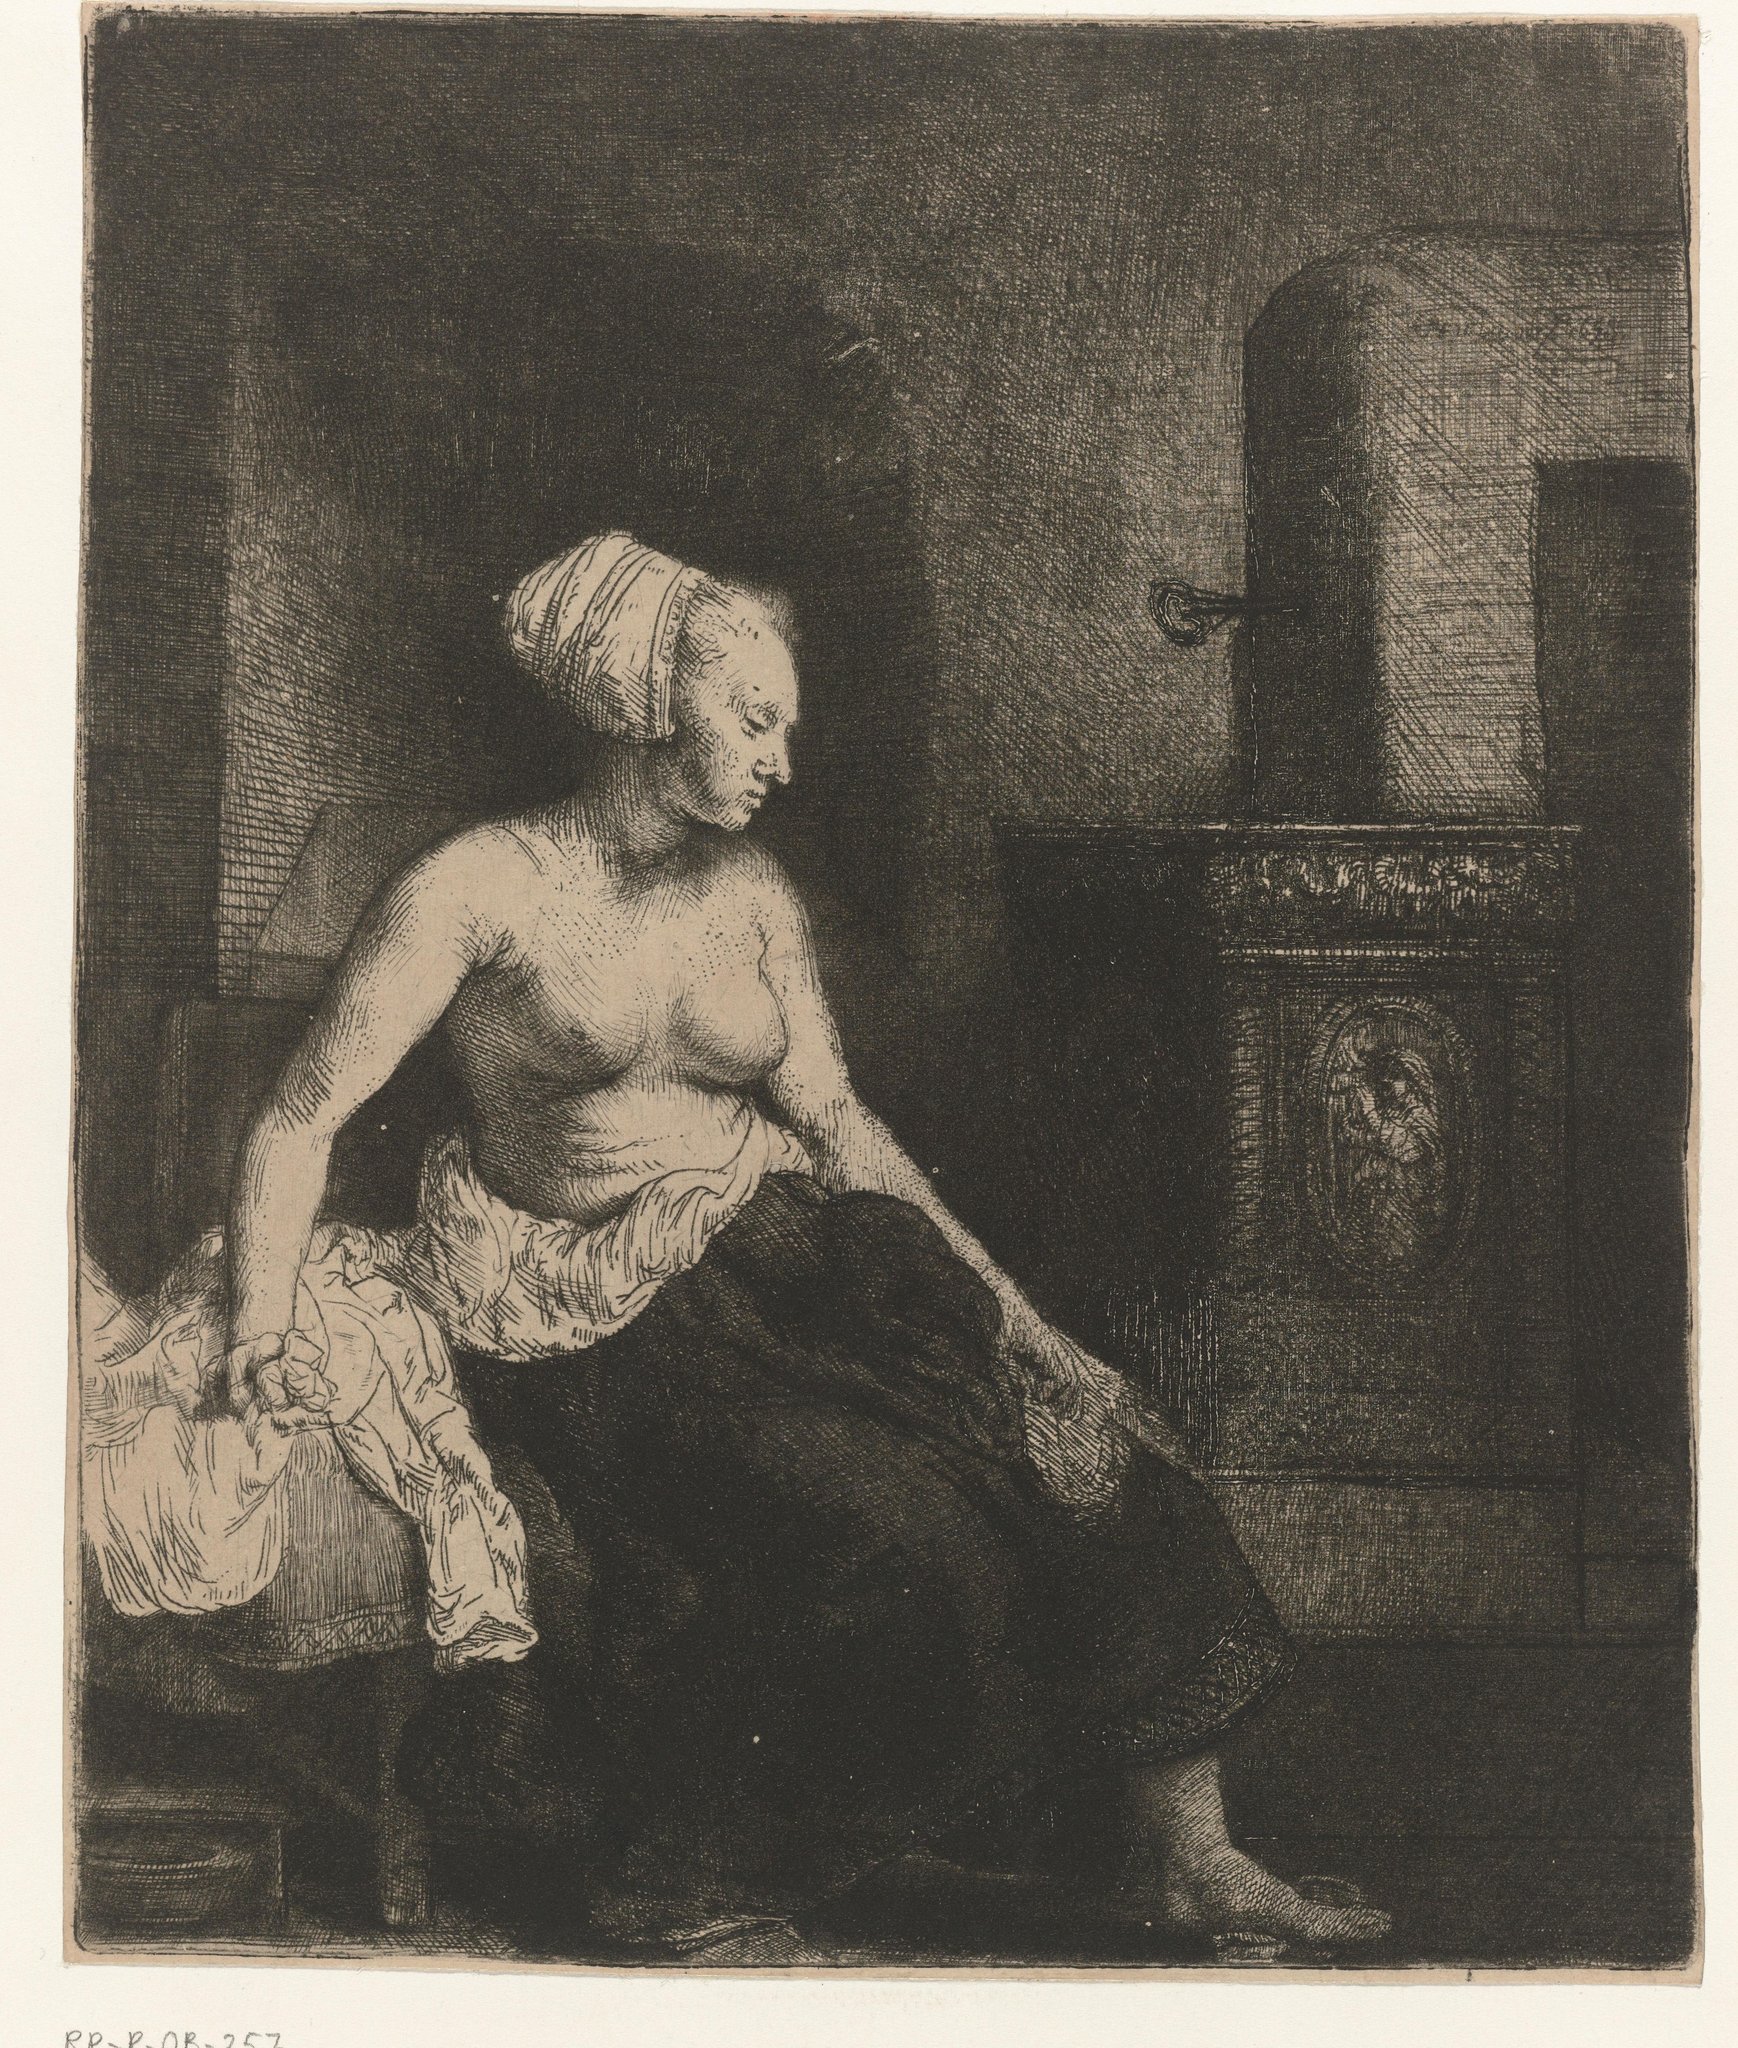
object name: print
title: Woman sitting half dressed beside a stove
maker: rembrandt van rijn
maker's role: draughtsman, painter, print maker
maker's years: 1606-1669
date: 1658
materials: paper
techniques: drypoint, etching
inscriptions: collector's mark: Lugt 240, signature and date: ‘Rembrandt f. 1658’